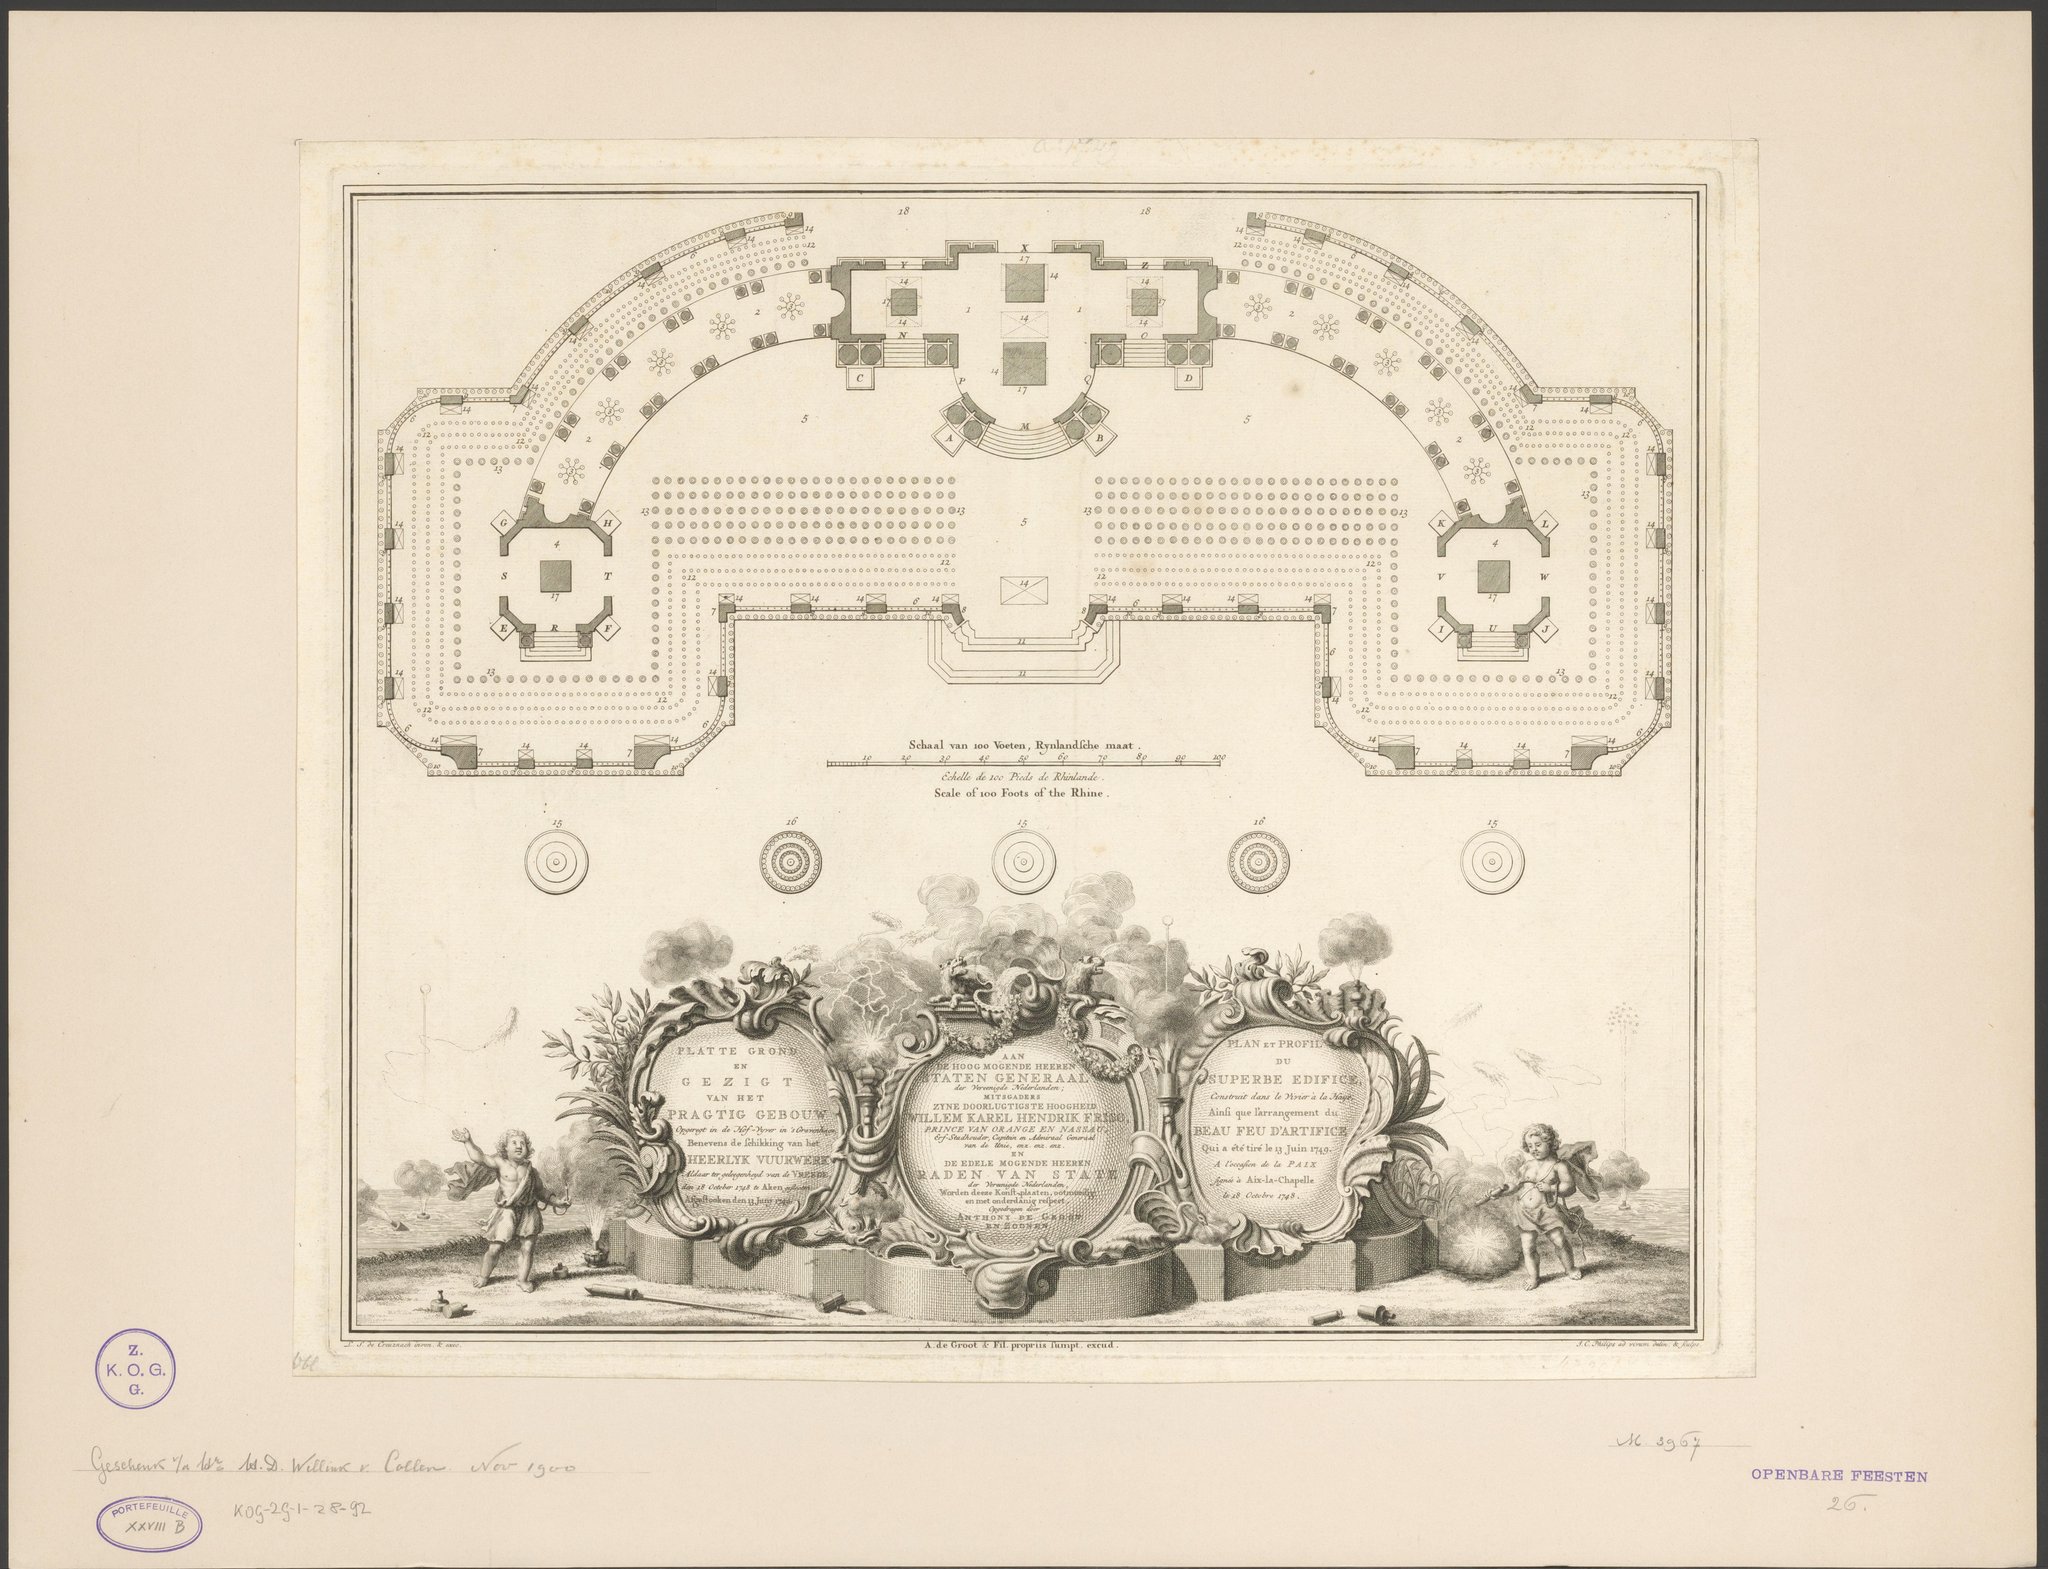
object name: print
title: Theater te Den Haag voor het vuurwerk voor de Vrede van Aken, 1749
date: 1749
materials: paper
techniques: engraving, etching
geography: the hague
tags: bonfire, fire-works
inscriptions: collector's mark: Lugt 1641, stamp, stamp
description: Plattegrond van het grote theater opgericht in de Hofvijver te Den Haag. Het werd op 13 juni 1749 gebruikt voor het vuurwerk ter ere van de Vrede van Aken gesloten in 1748. Onderaan cartouches met de titels in het Nederlands en Frans en de opdrachten, met twee figuurtjes met brandende lonten. Bij de plattegrond behoren een voorstelling van het vuurwerk en een tekstblad met verklaring. Onderwerpsrubrieken binnen de Atlas Zeden en Gewoonten: Zeden en Gewoonten in Engeren Zin. Volksleven. Openbare feesten. Vorstelijke intochten, (Illuminaties, vuurwerken en dergelijke, openbare feesten).